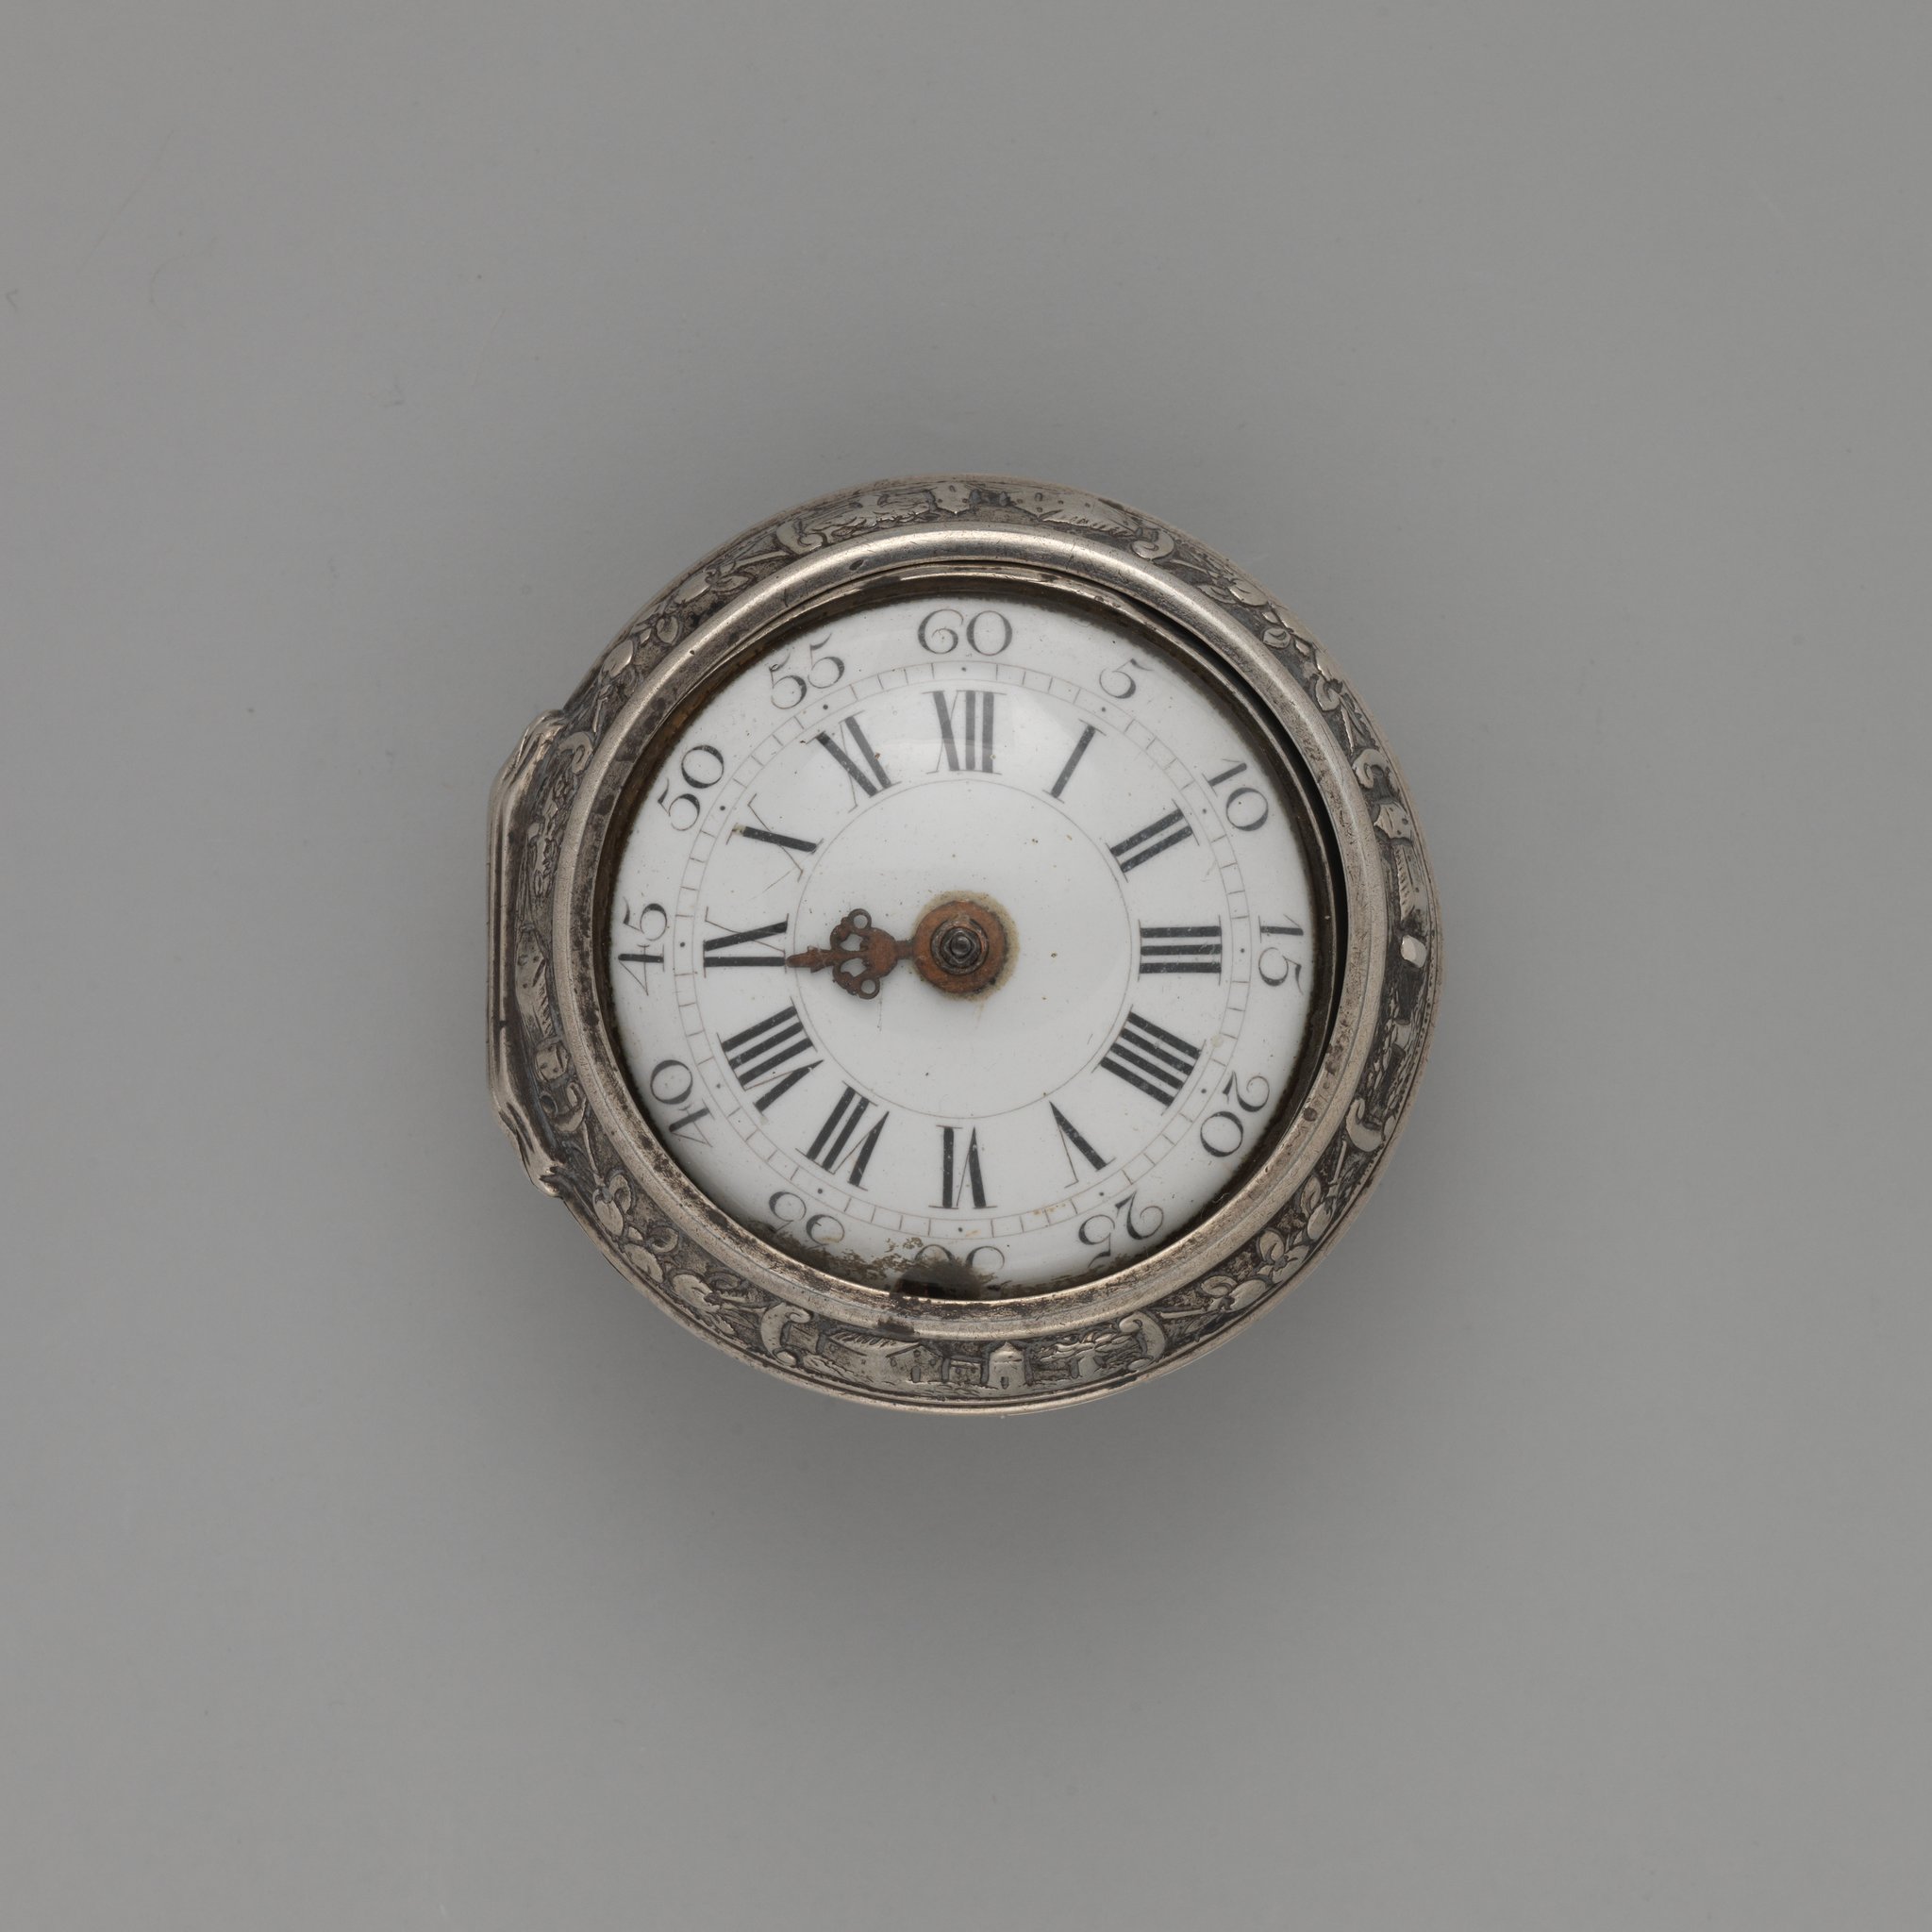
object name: watch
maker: debeaufré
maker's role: maker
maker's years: 1700-1800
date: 1701-1800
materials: enamel, silver